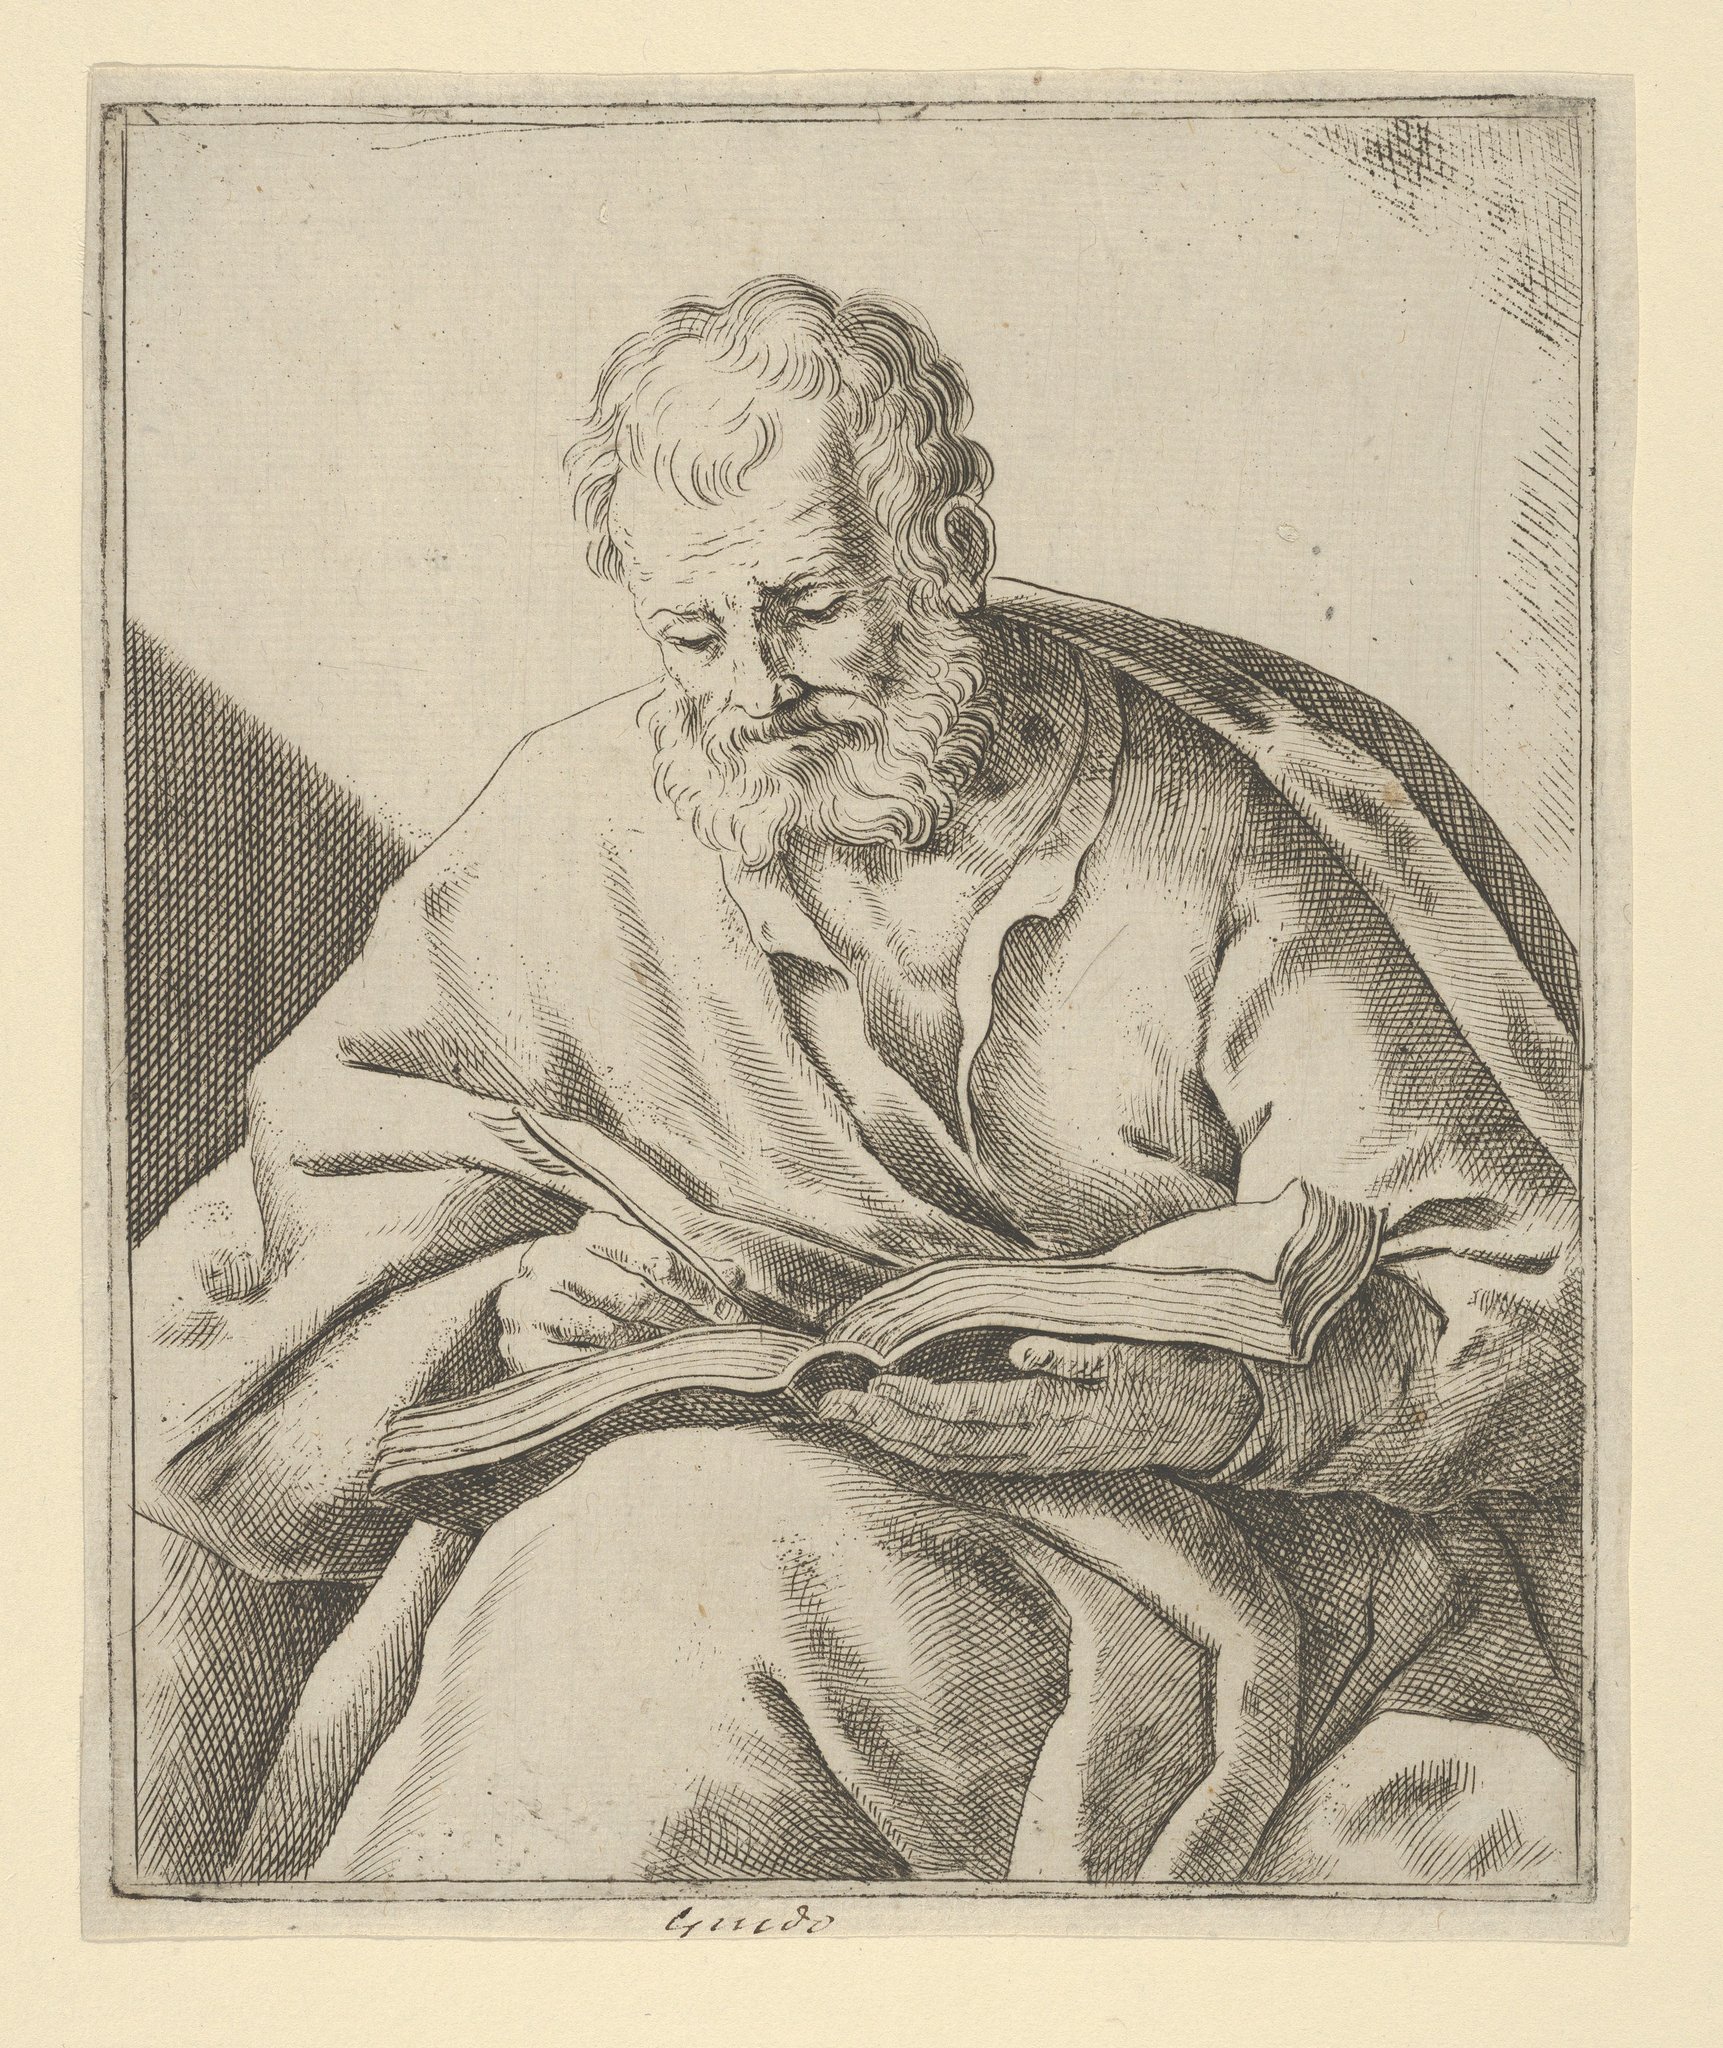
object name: print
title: An old man seated and writing in a book (an evangelist?)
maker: Anonymous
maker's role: artist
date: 1601-1700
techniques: etching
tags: books,men,writing